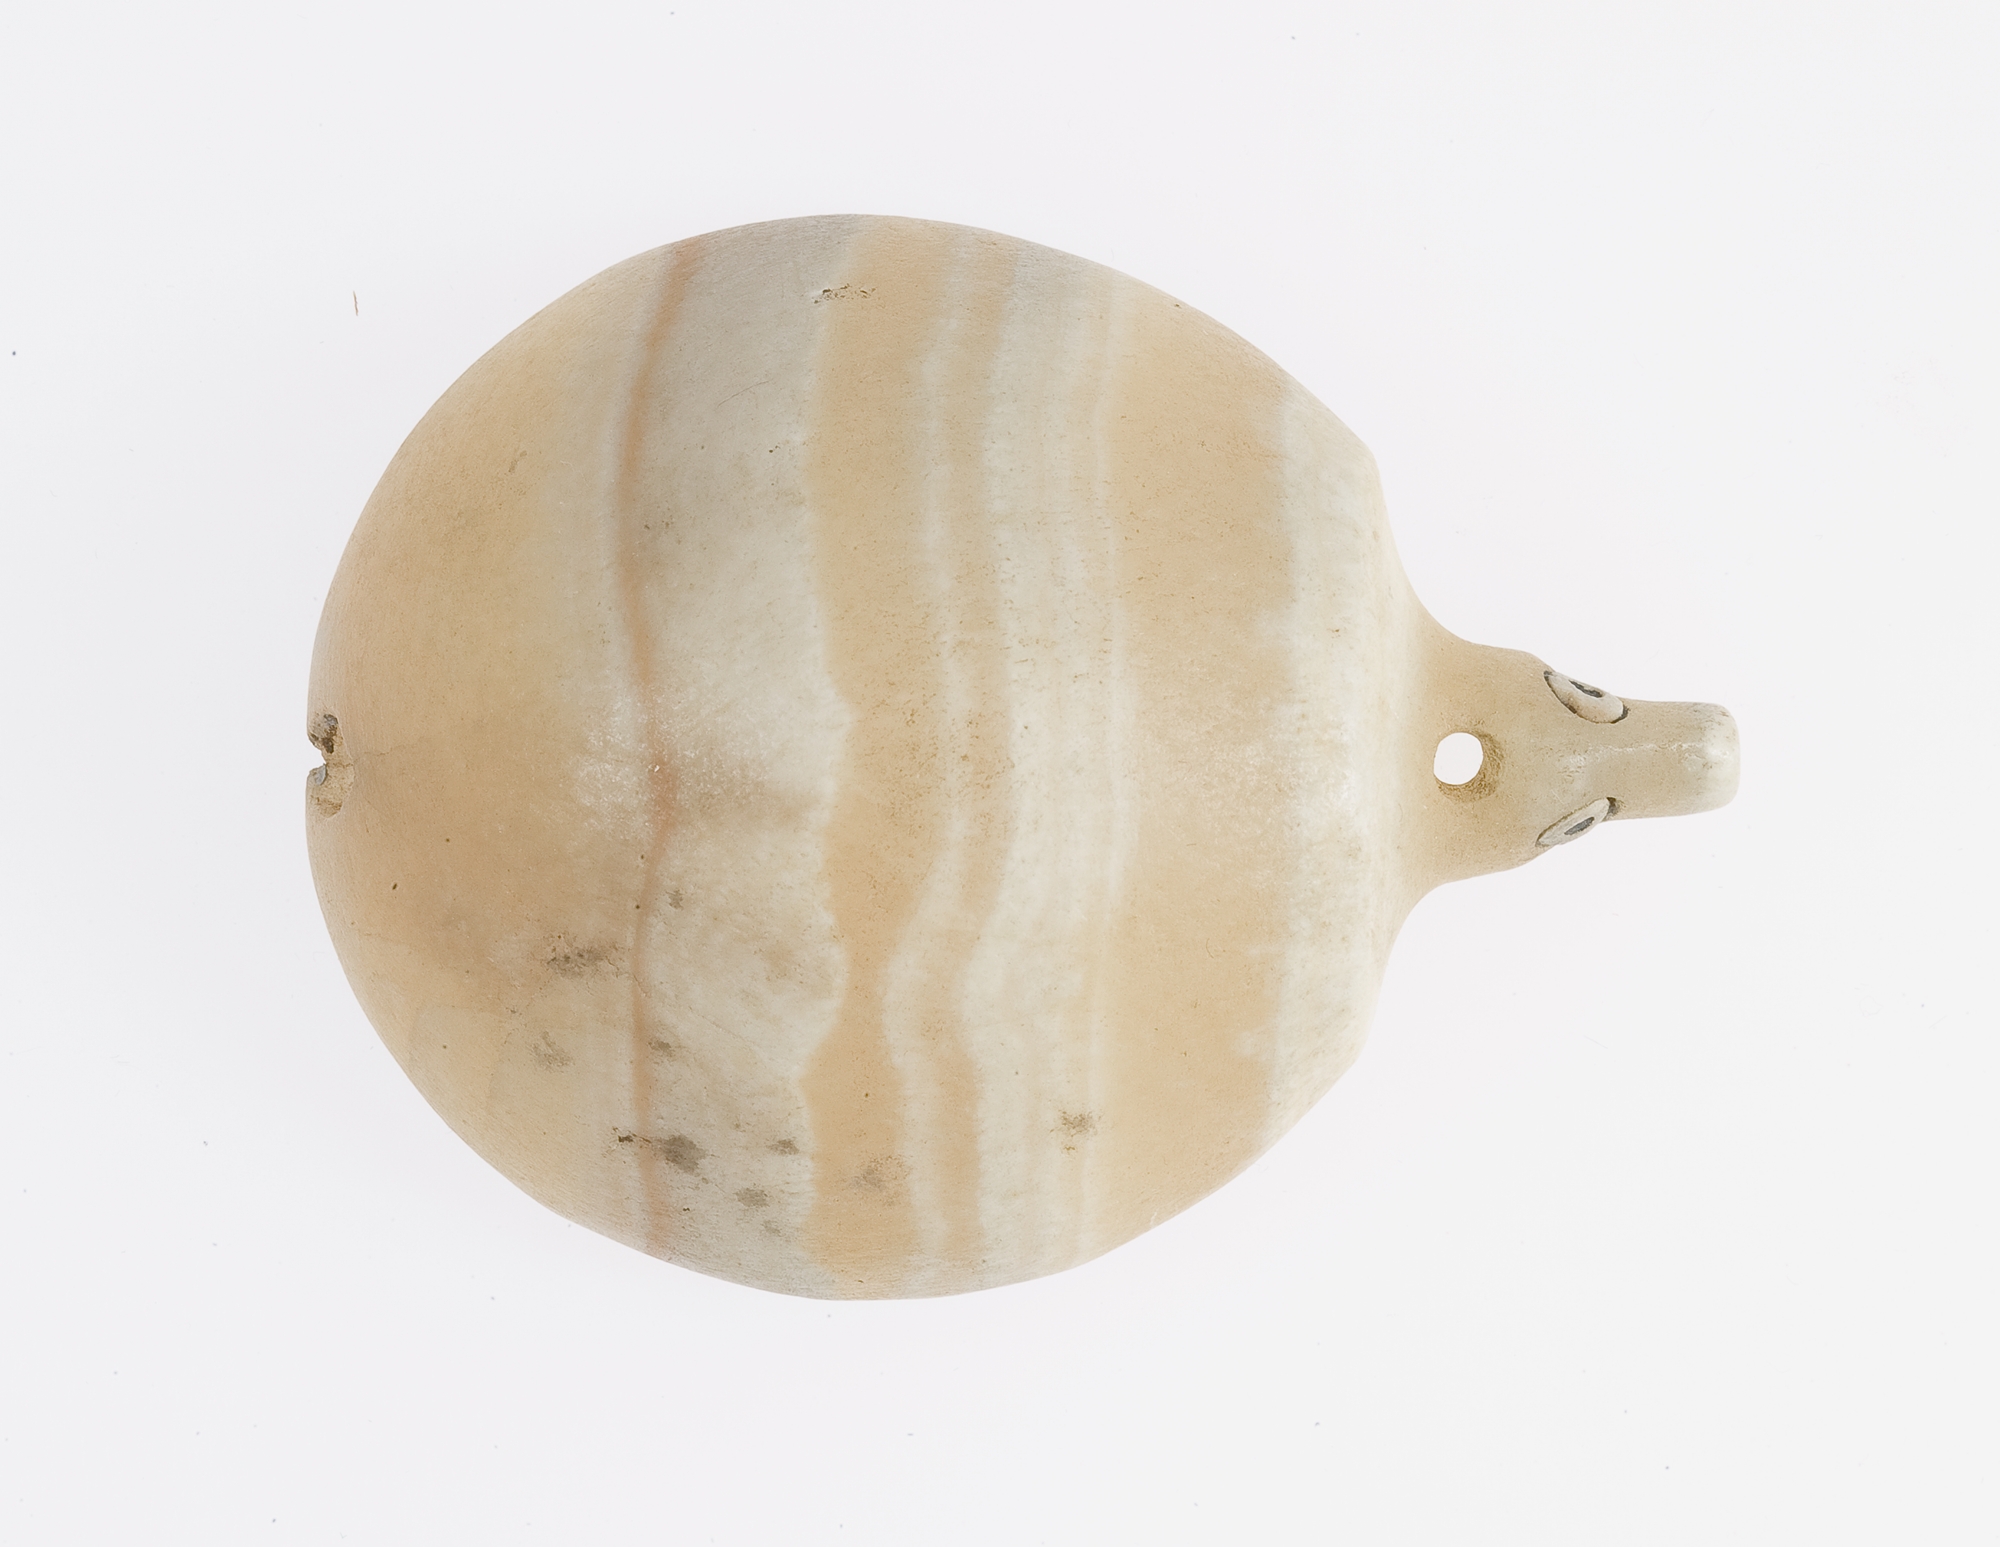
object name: vessel lid, turtle shaped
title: Vessel lid in the form of a turtle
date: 3500-2650 BCE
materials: paste, stone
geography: egypt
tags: turtles